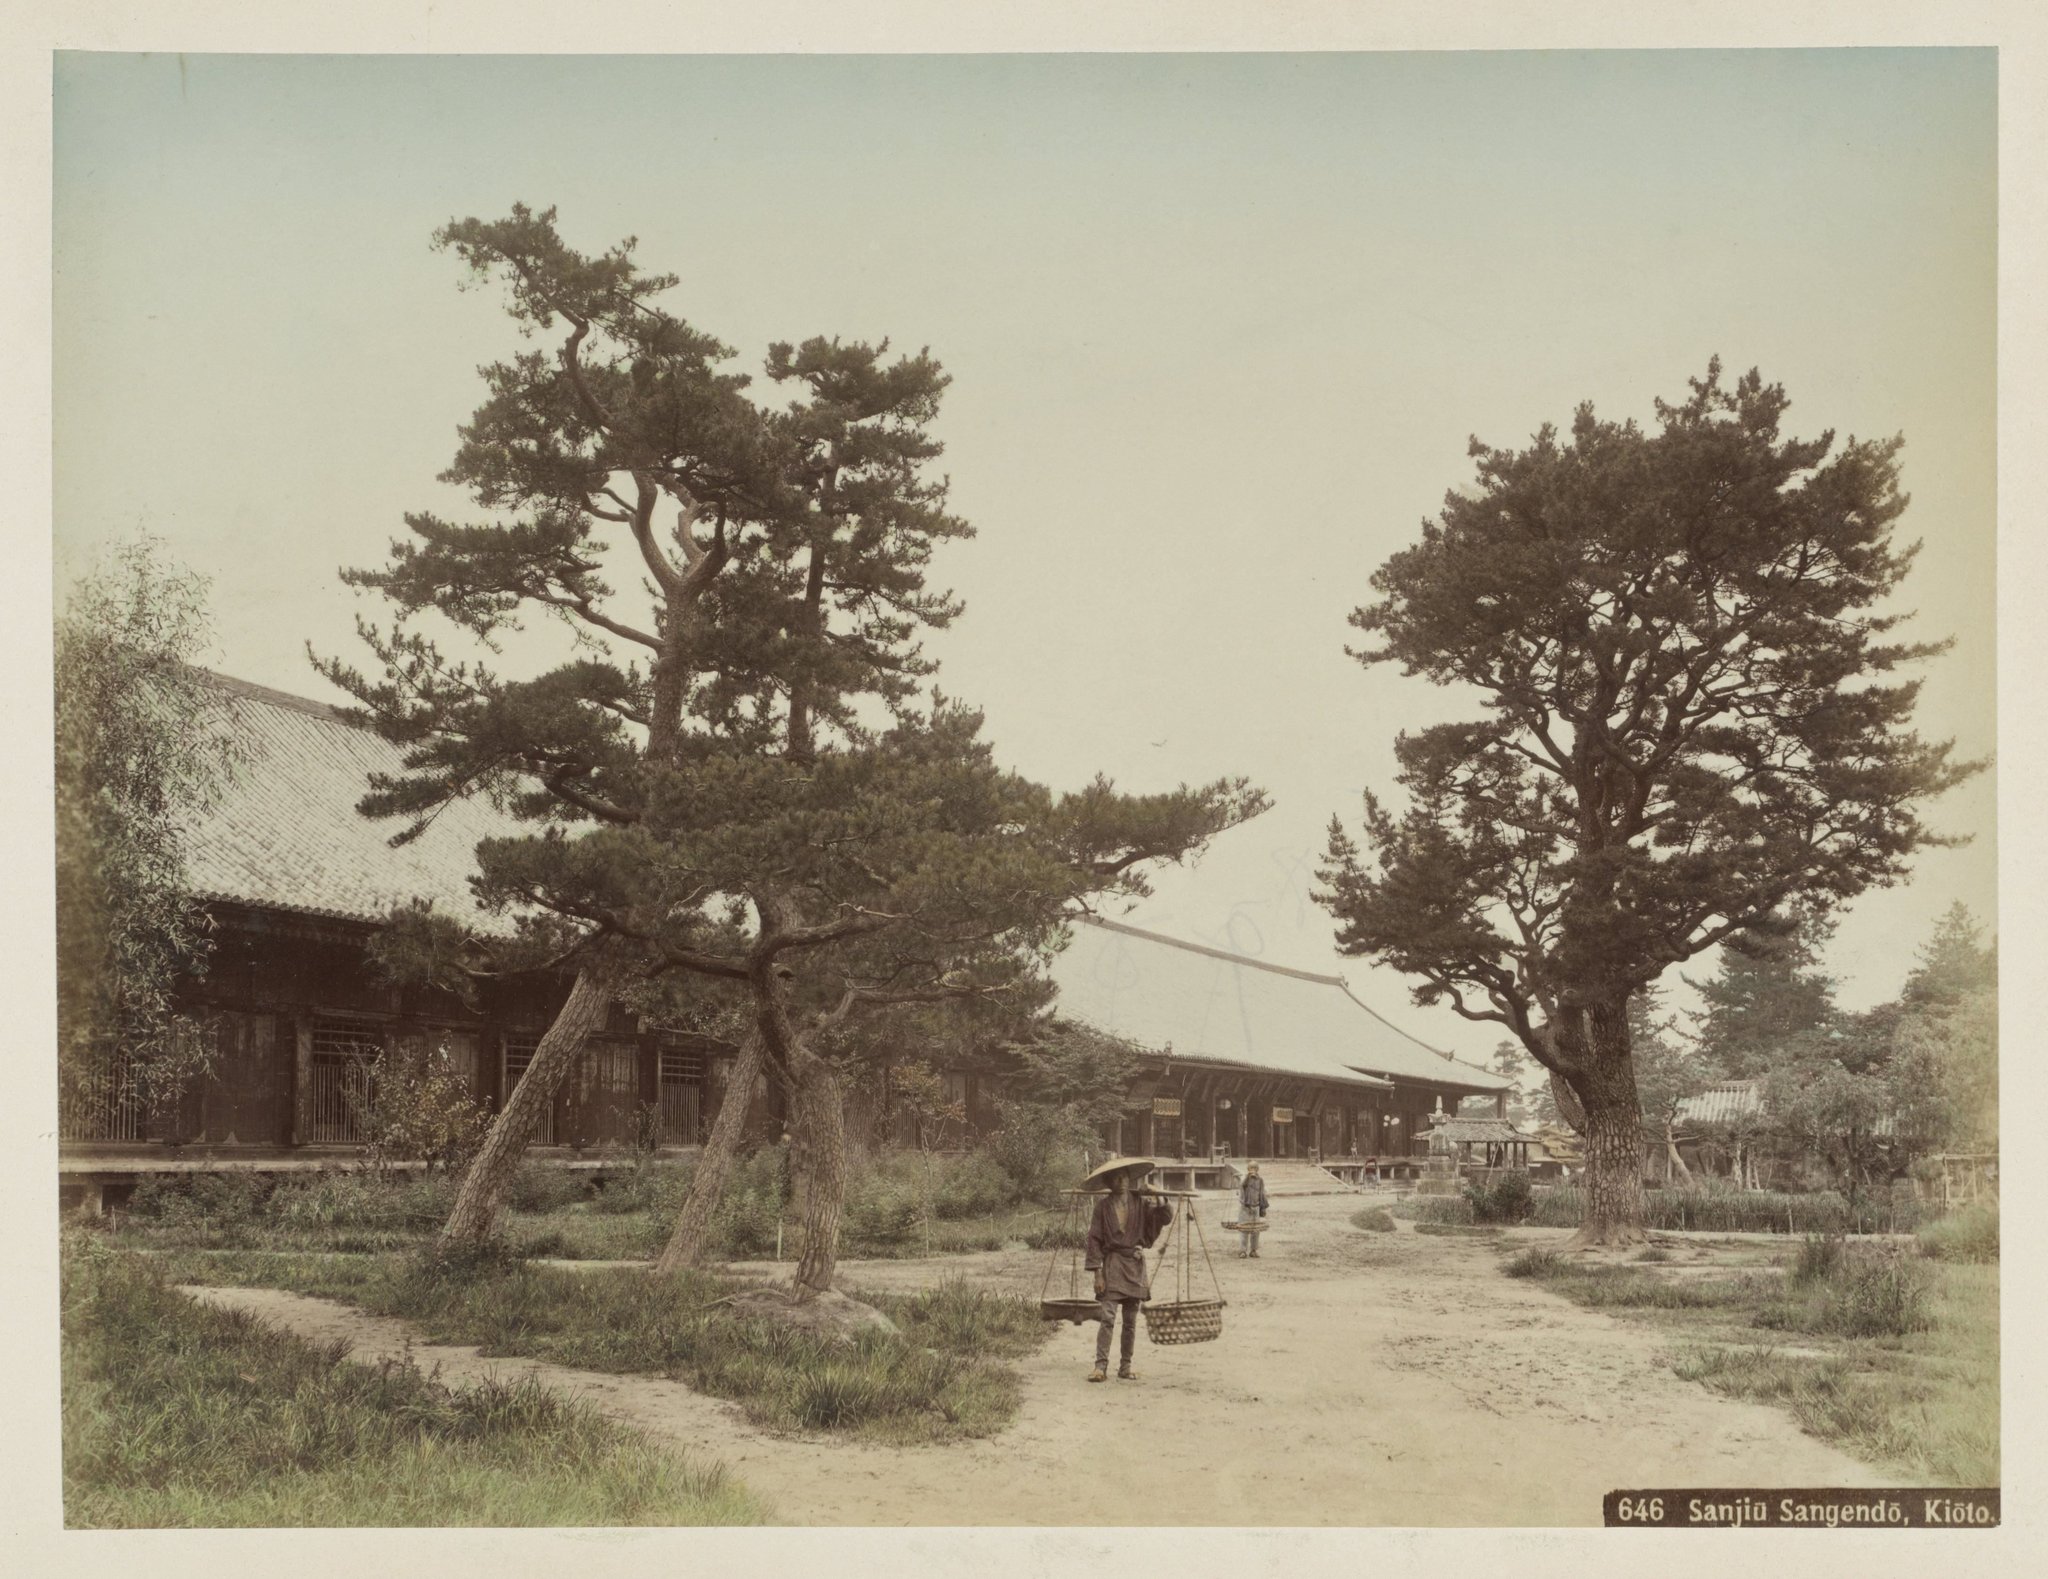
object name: photograph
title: Tempel van Sanjiu Sangendo in Kyoto met op de voorgrond een man met een draagstok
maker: Anonymous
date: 1870-1900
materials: paper, photographic support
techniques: albumen print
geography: kyoto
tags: carrying something with carrying-pole, trees, head-gear: hat (+ men's clothes), travelling; tourism, temple, shrine ~ islam, mohammedanism, kyoto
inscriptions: negative number: ‘646’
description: Onderdeel van Fotoalbum met 50 foto's van bezienswaardigheden in Japan.